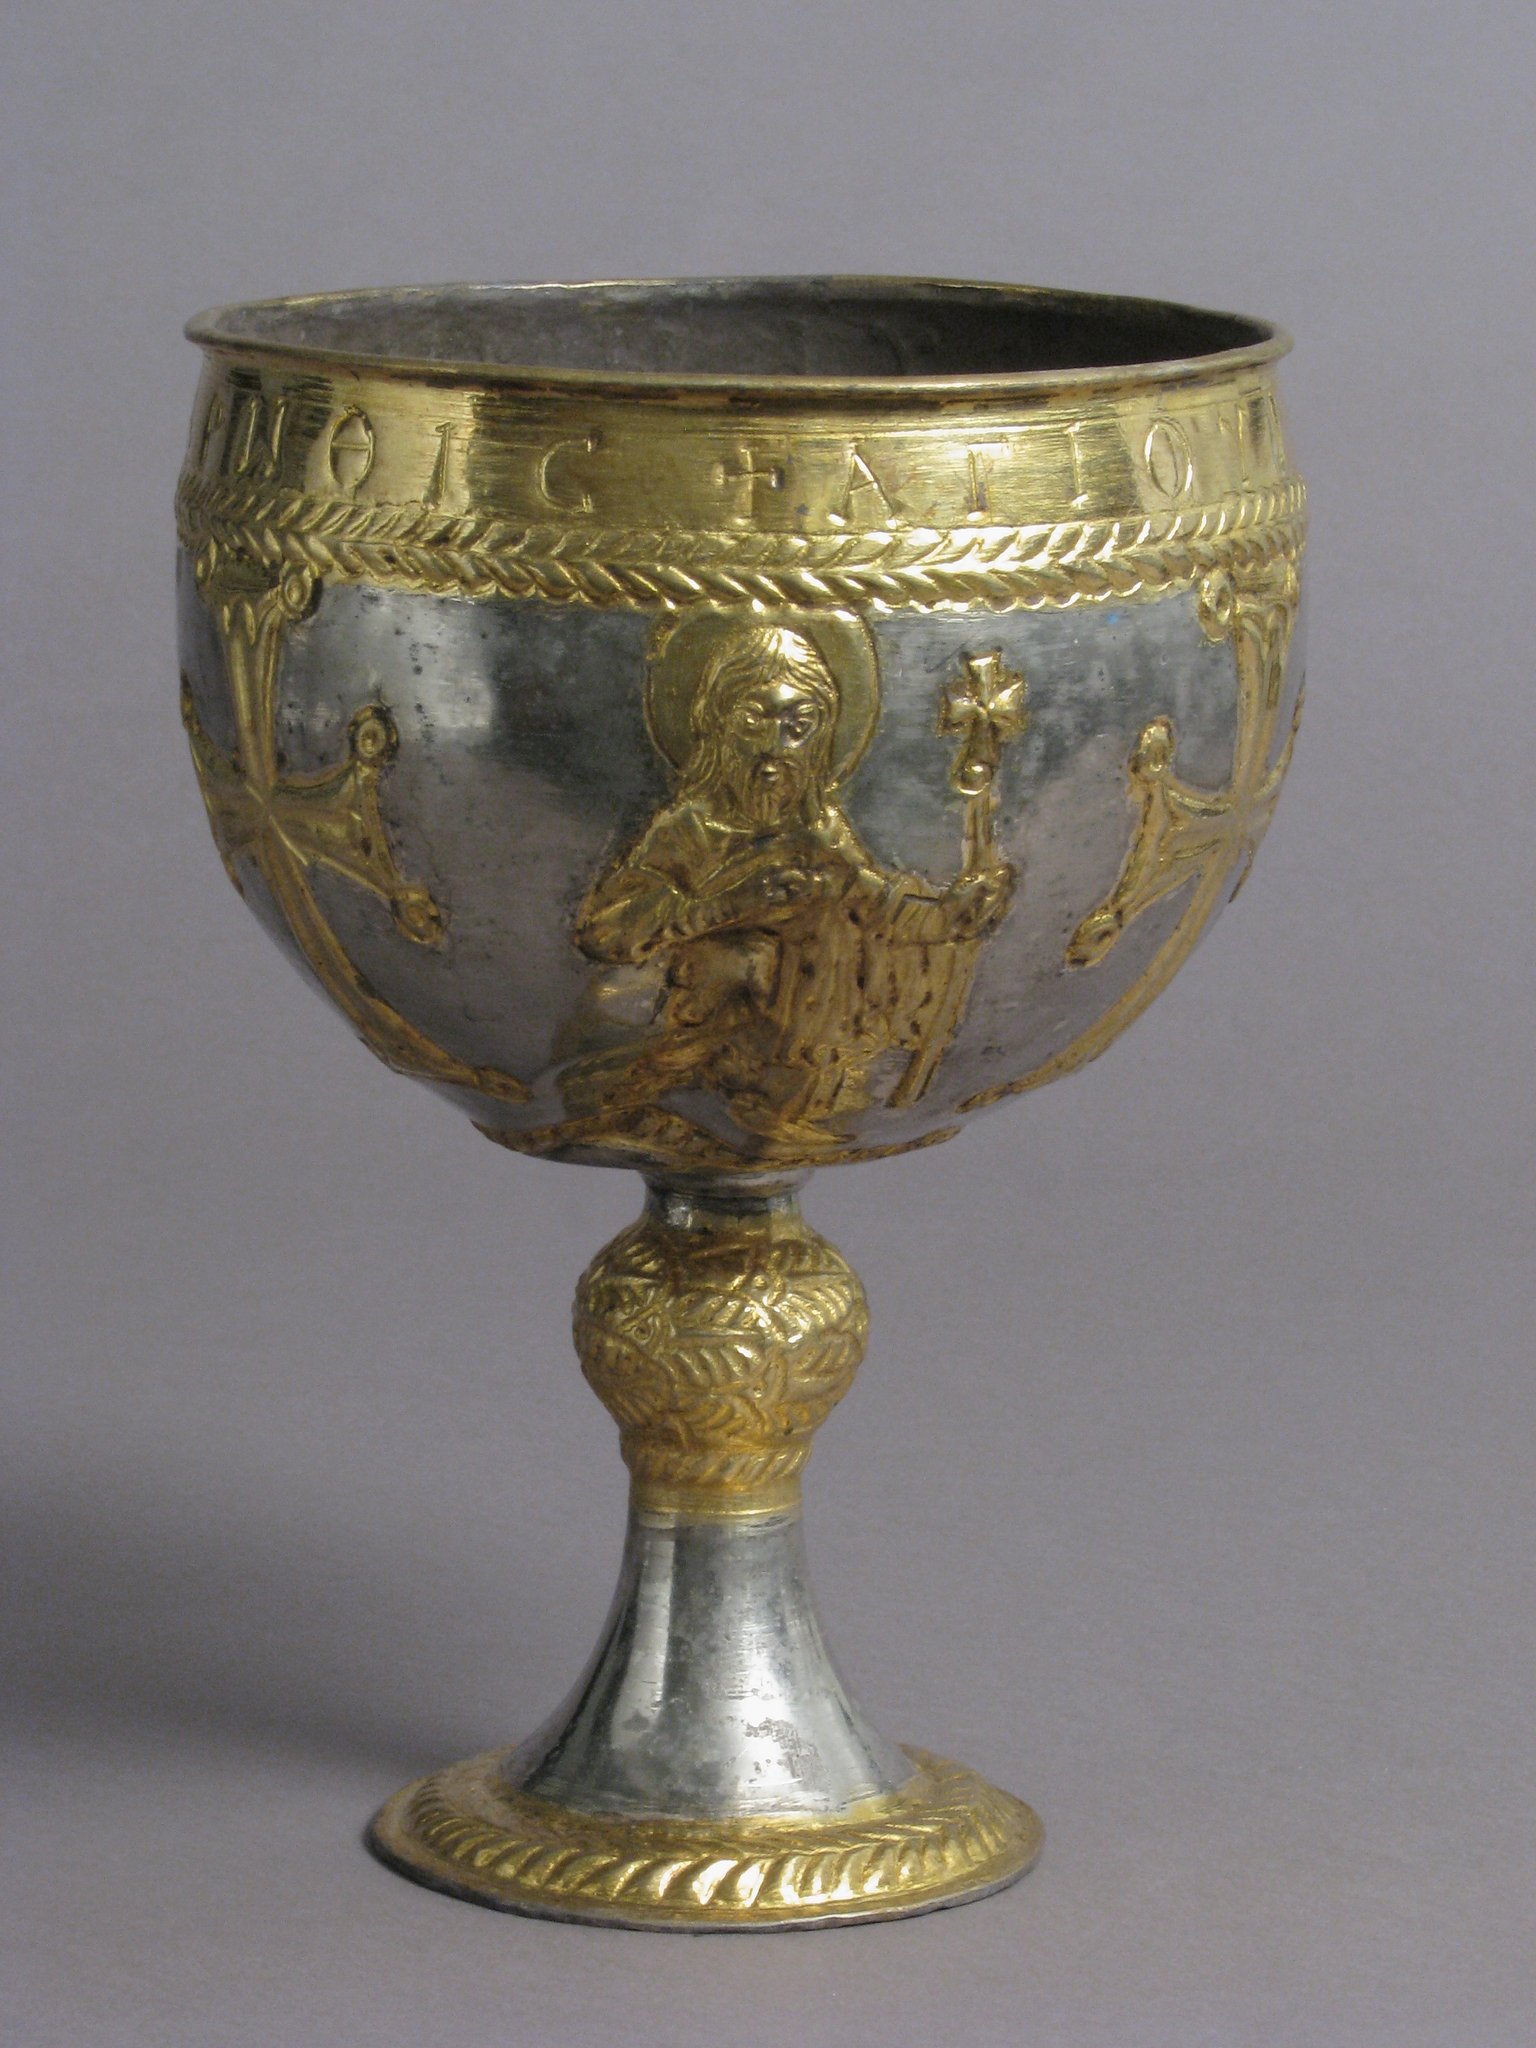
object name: chalice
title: The Attarouthi Treasure - Chalice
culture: byzantine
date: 500-650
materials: gilt silver, silver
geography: syria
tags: bishops,saints